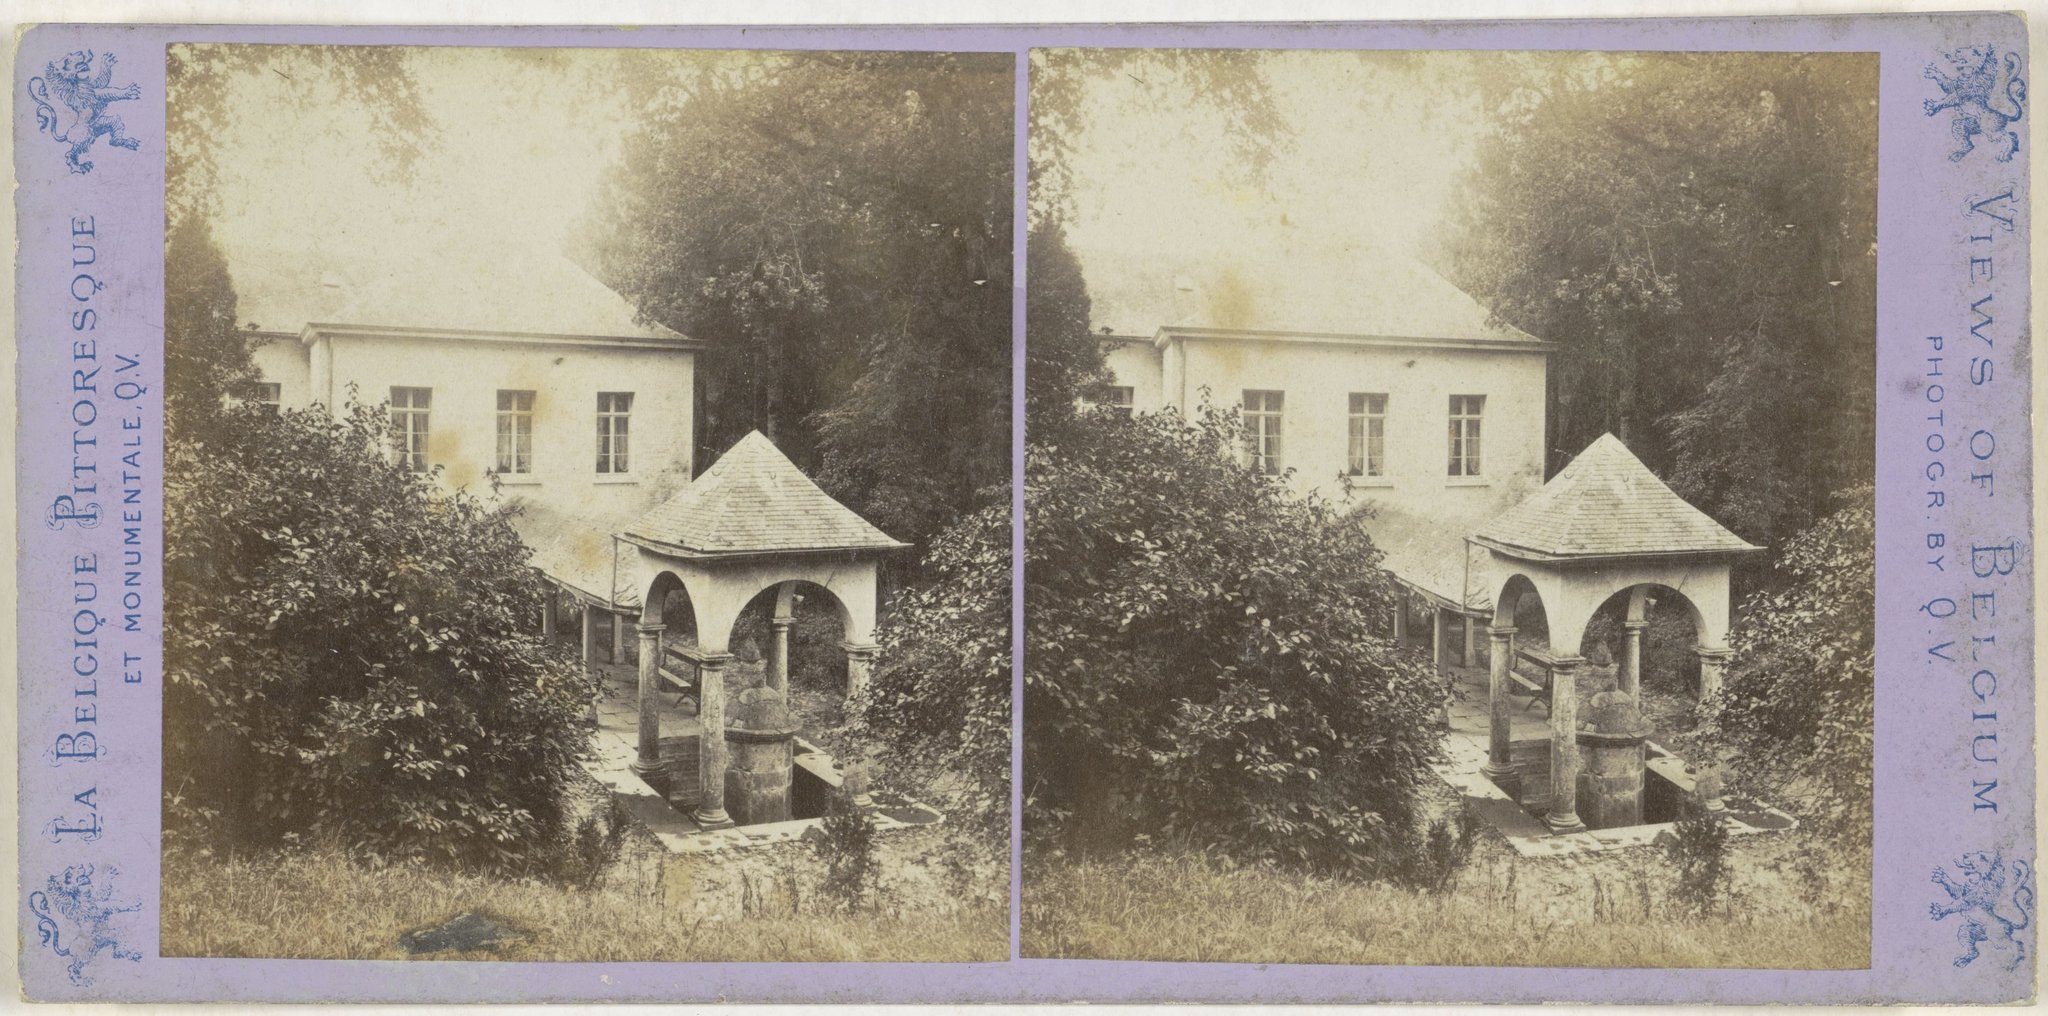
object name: stereograph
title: La Belgique pittoresque et monumentale / Views of Belgium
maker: jules hippolyte quéval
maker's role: publisher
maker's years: 1824-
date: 1866-1870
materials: cardboard, paper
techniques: albumen print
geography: spa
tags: spring, source of river or stream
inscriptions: number: ‘No 1785’